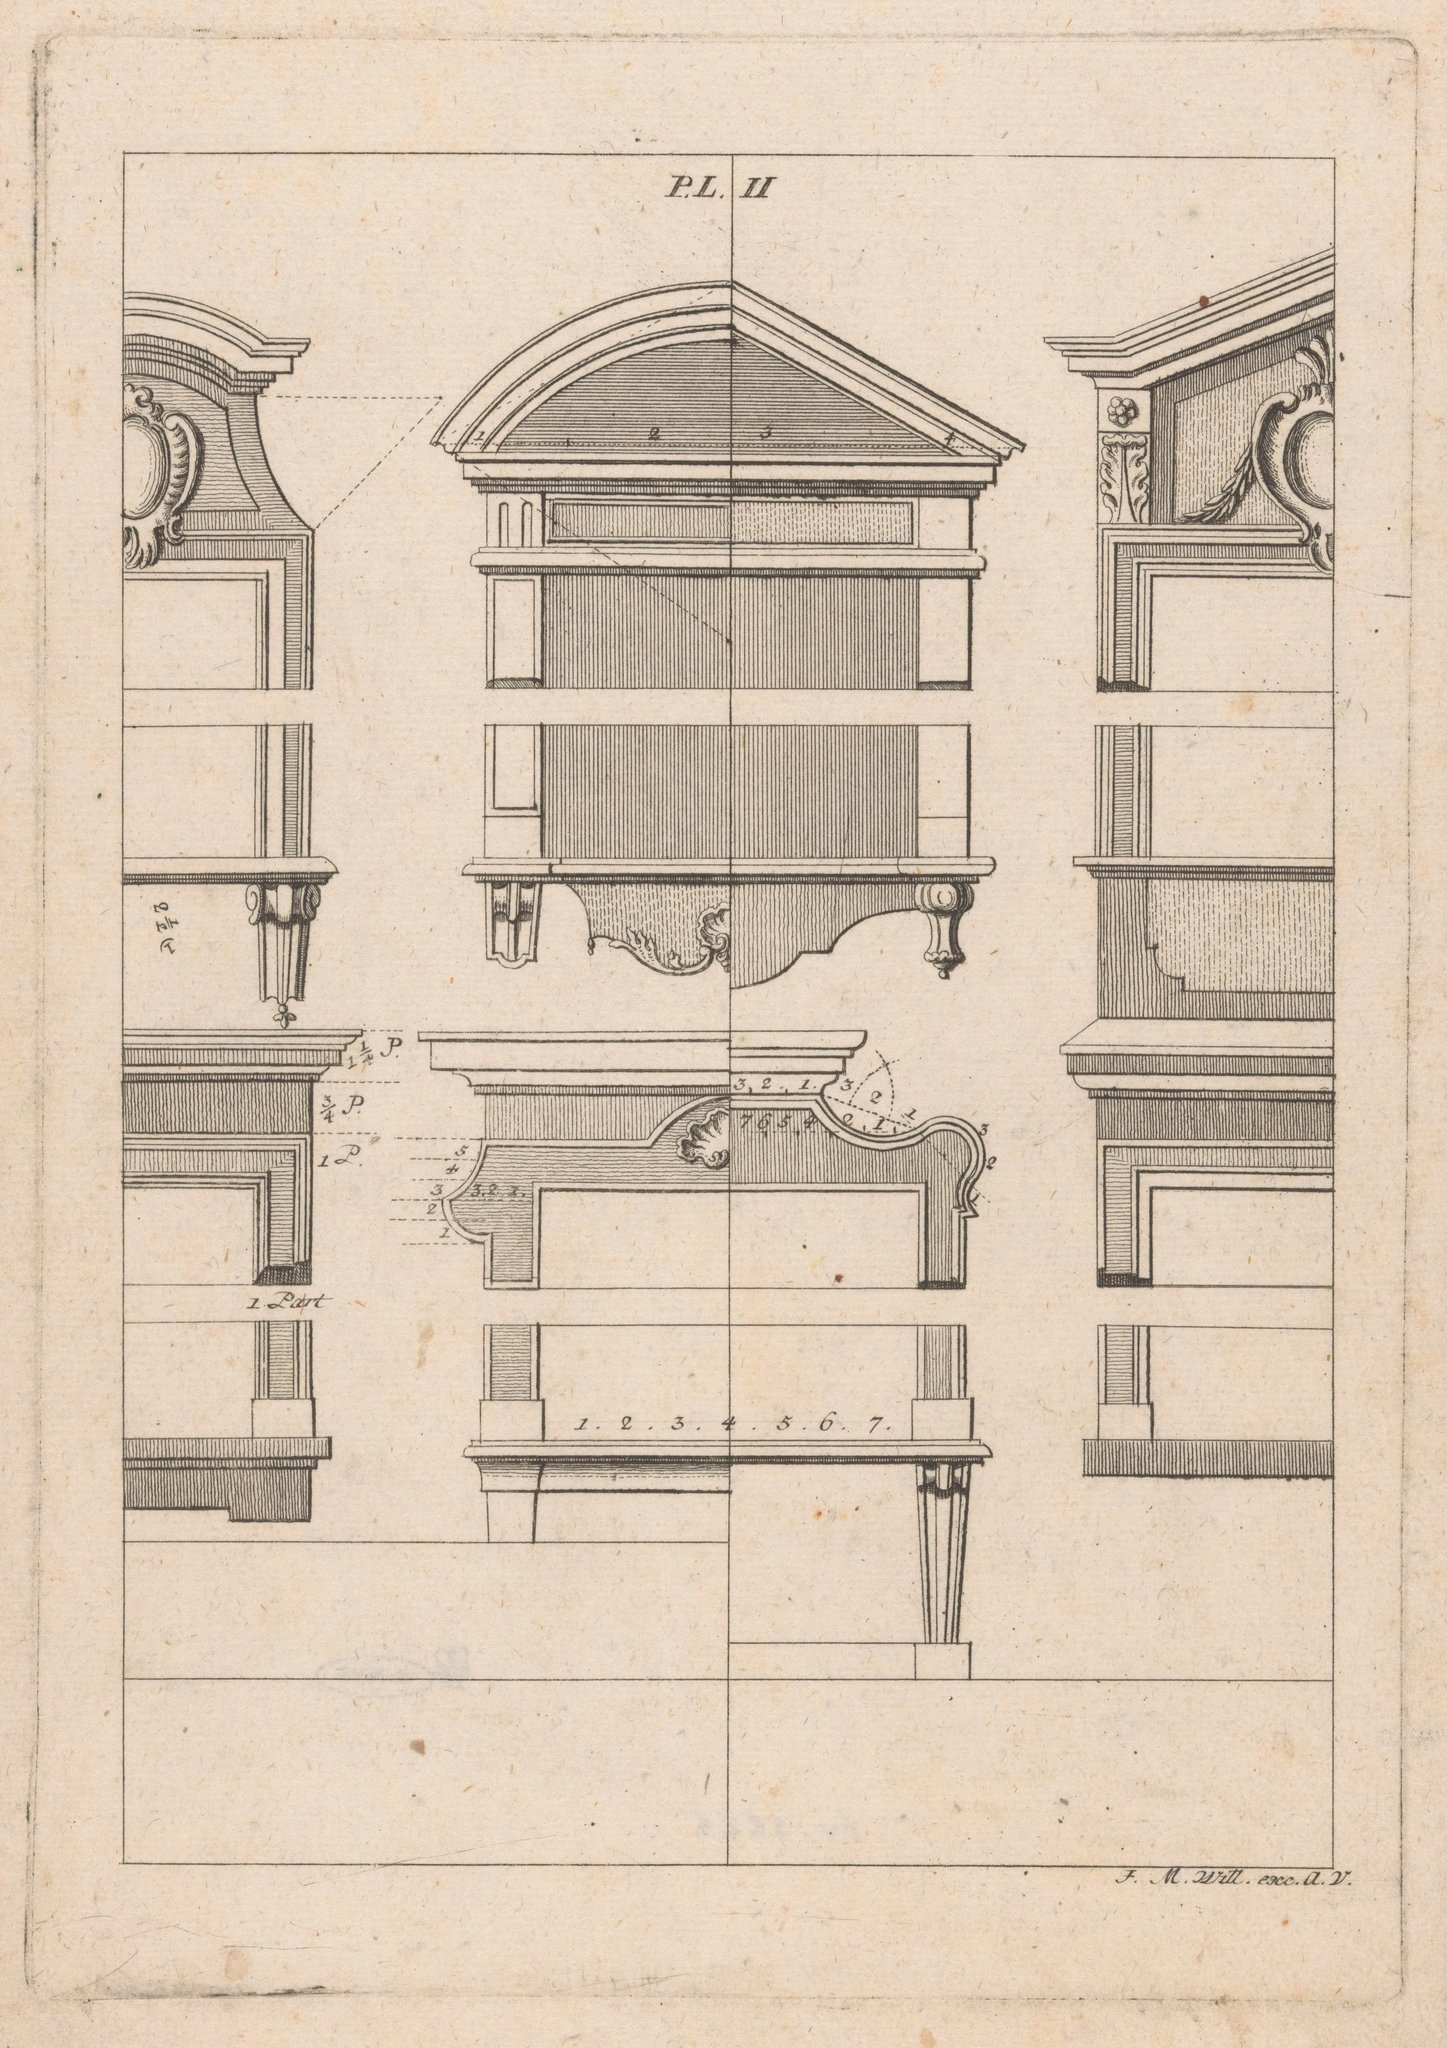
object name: ornament print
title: Anleitung nach Mustern Fenster, Thüren und Thorwegen, nach Geometrischen Gründen (...)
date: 1788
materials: paper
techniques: engraving, etching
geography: augsburg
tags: ornaments ~ art (+ framing decorations), door, ornament ~ cartouche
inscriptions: collector's mark: Lugt 2228, collector's mark: Lugt 2760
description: Ontwerpen voor omlijstingen met ornamenten en links en rechts met rocaille cartouche.